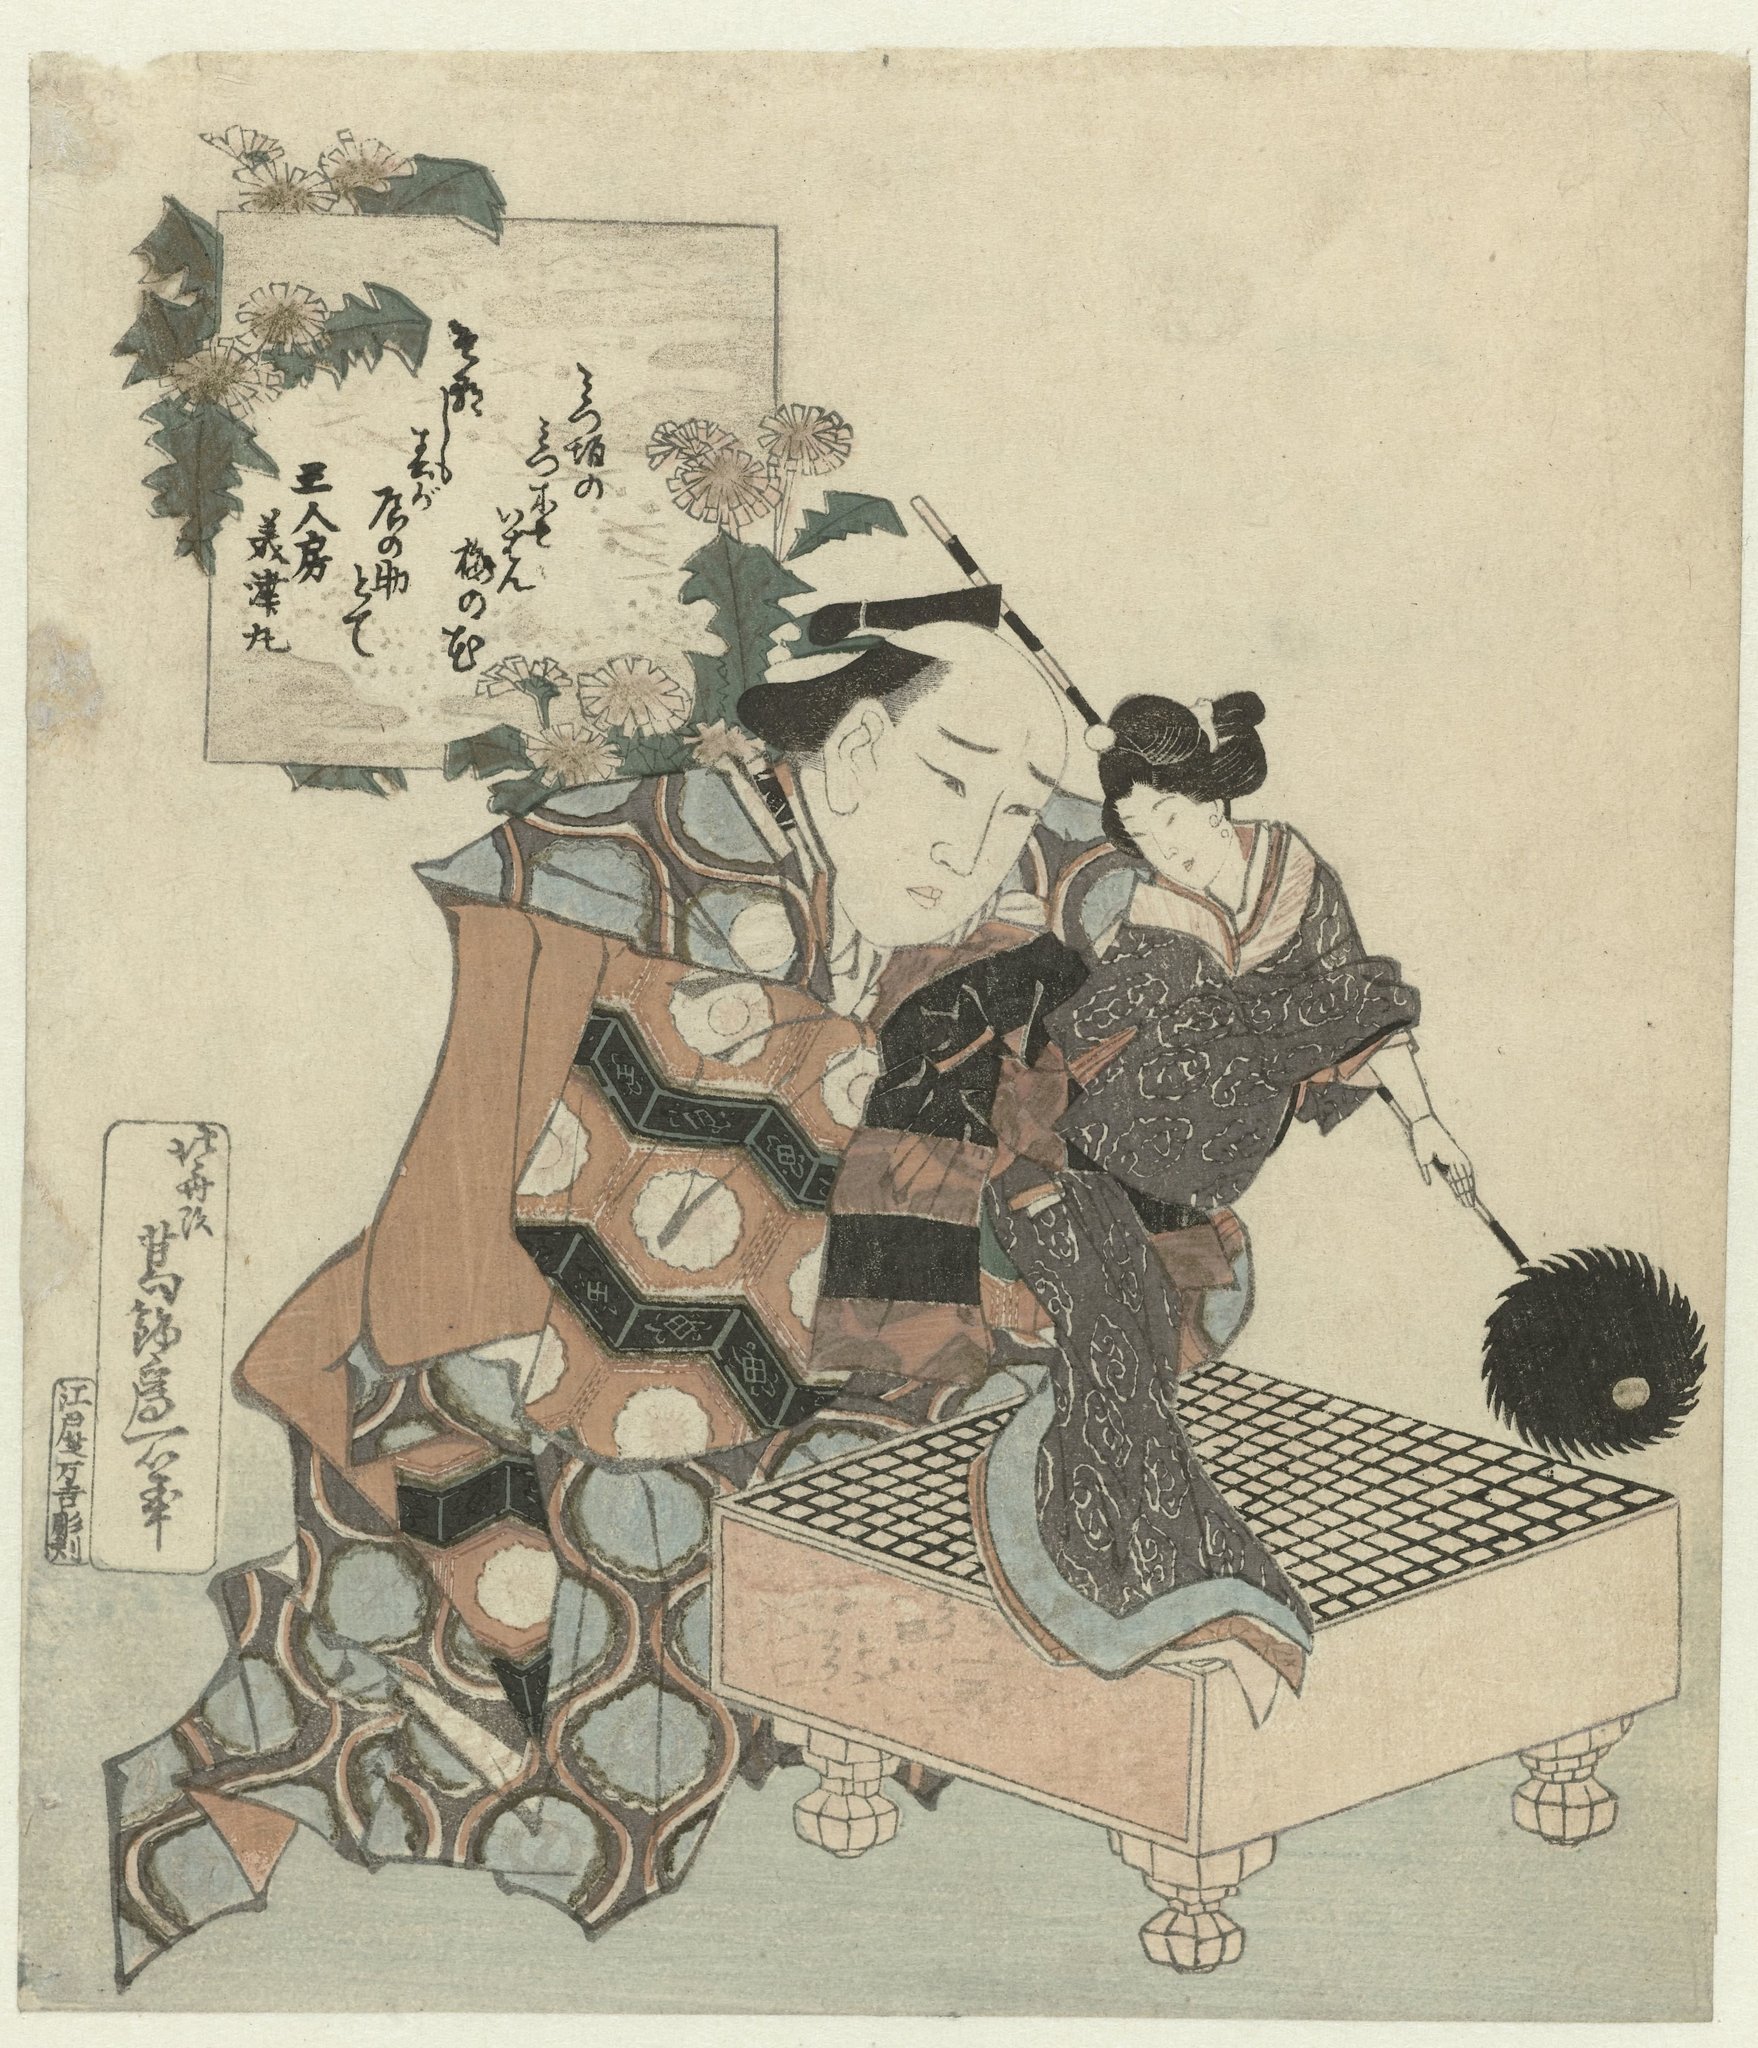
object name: print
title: Een poppenspeler met pop en gô speelbord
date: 1890-1900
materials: paper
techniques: woodcut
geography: japan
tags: puppet, adult man, board-games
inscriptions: collector's mark: Lugt 2228, collector's mark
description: Een poppenspeler met pop en een speelbord voor Japans schaken (gô). Met één gedicht. De prent is een b-kopie.